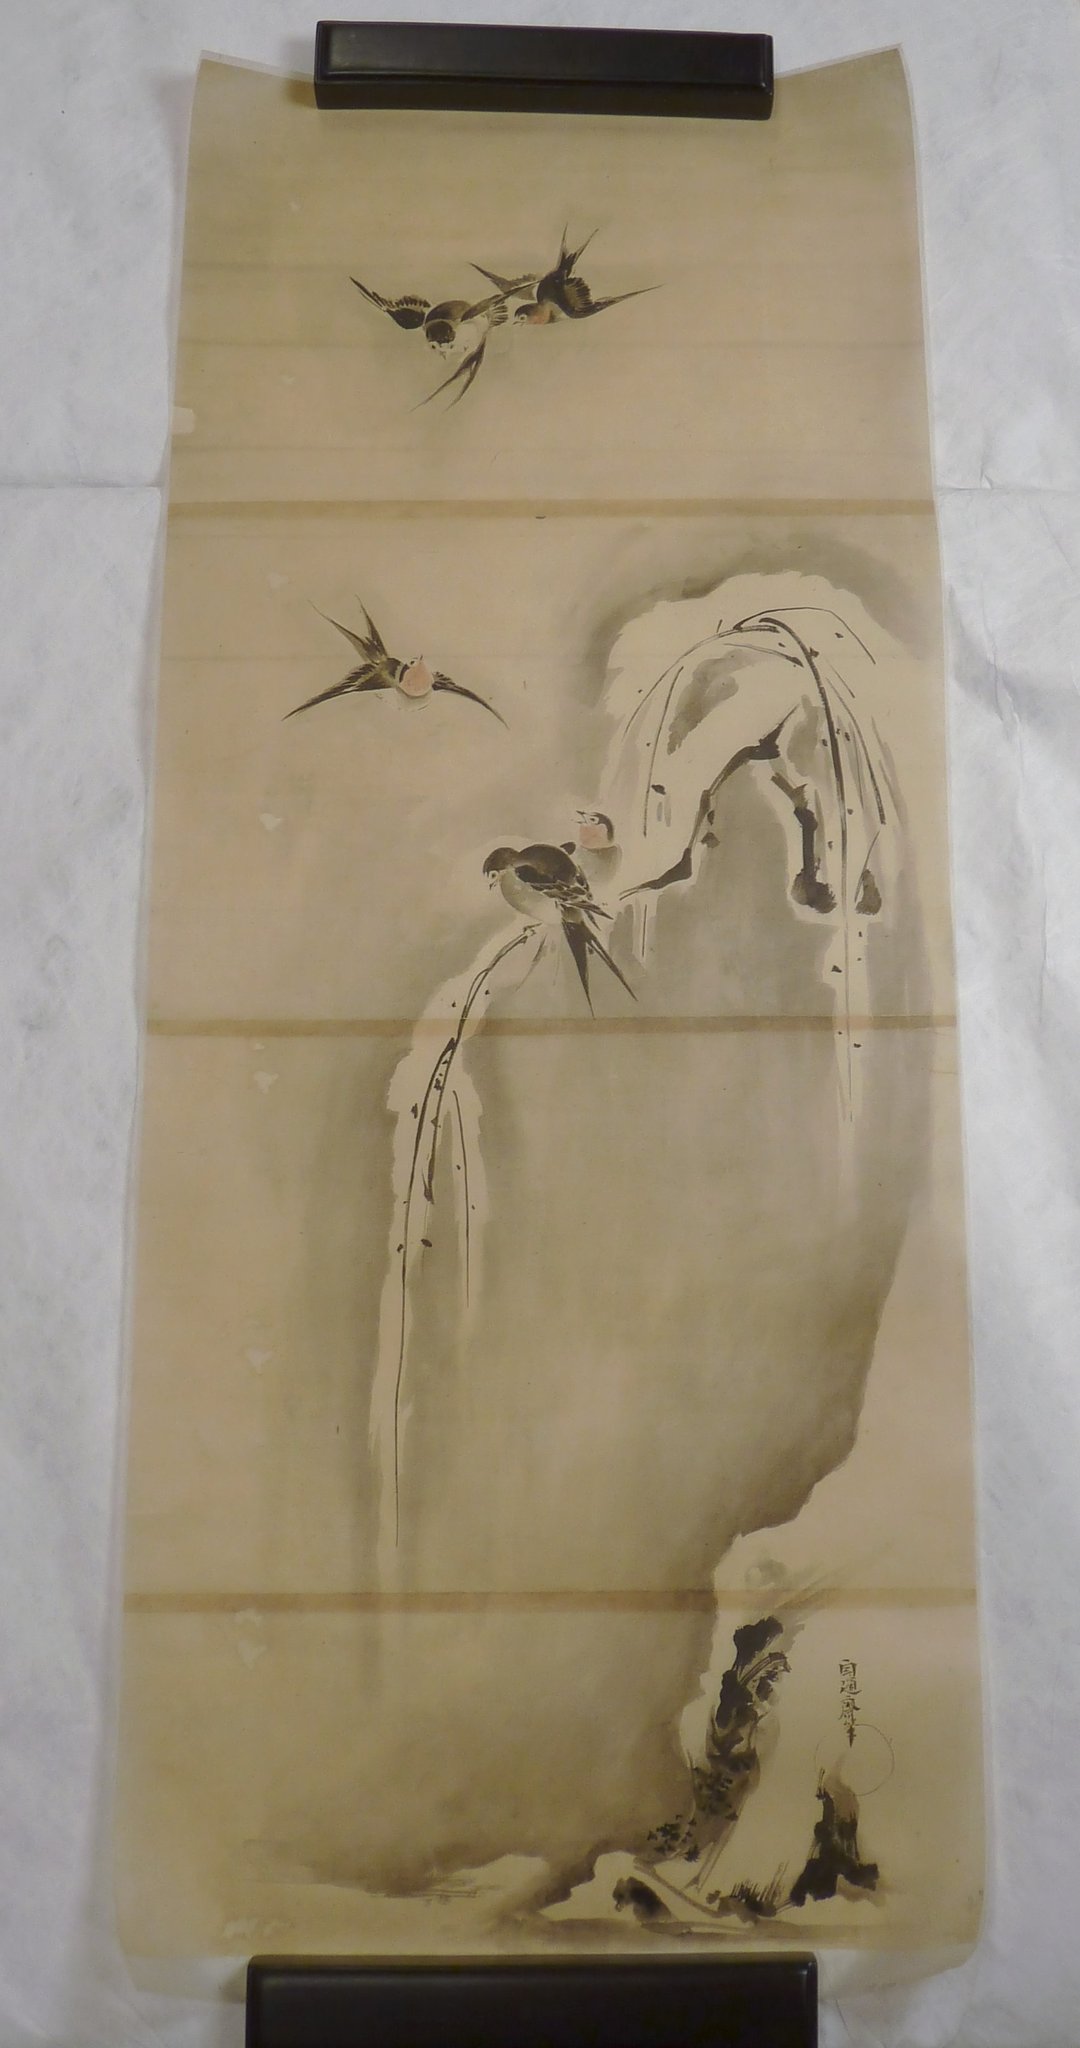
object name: drawing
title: Japanese Drawing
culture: japanese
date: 1801-1833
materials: paper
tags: birds